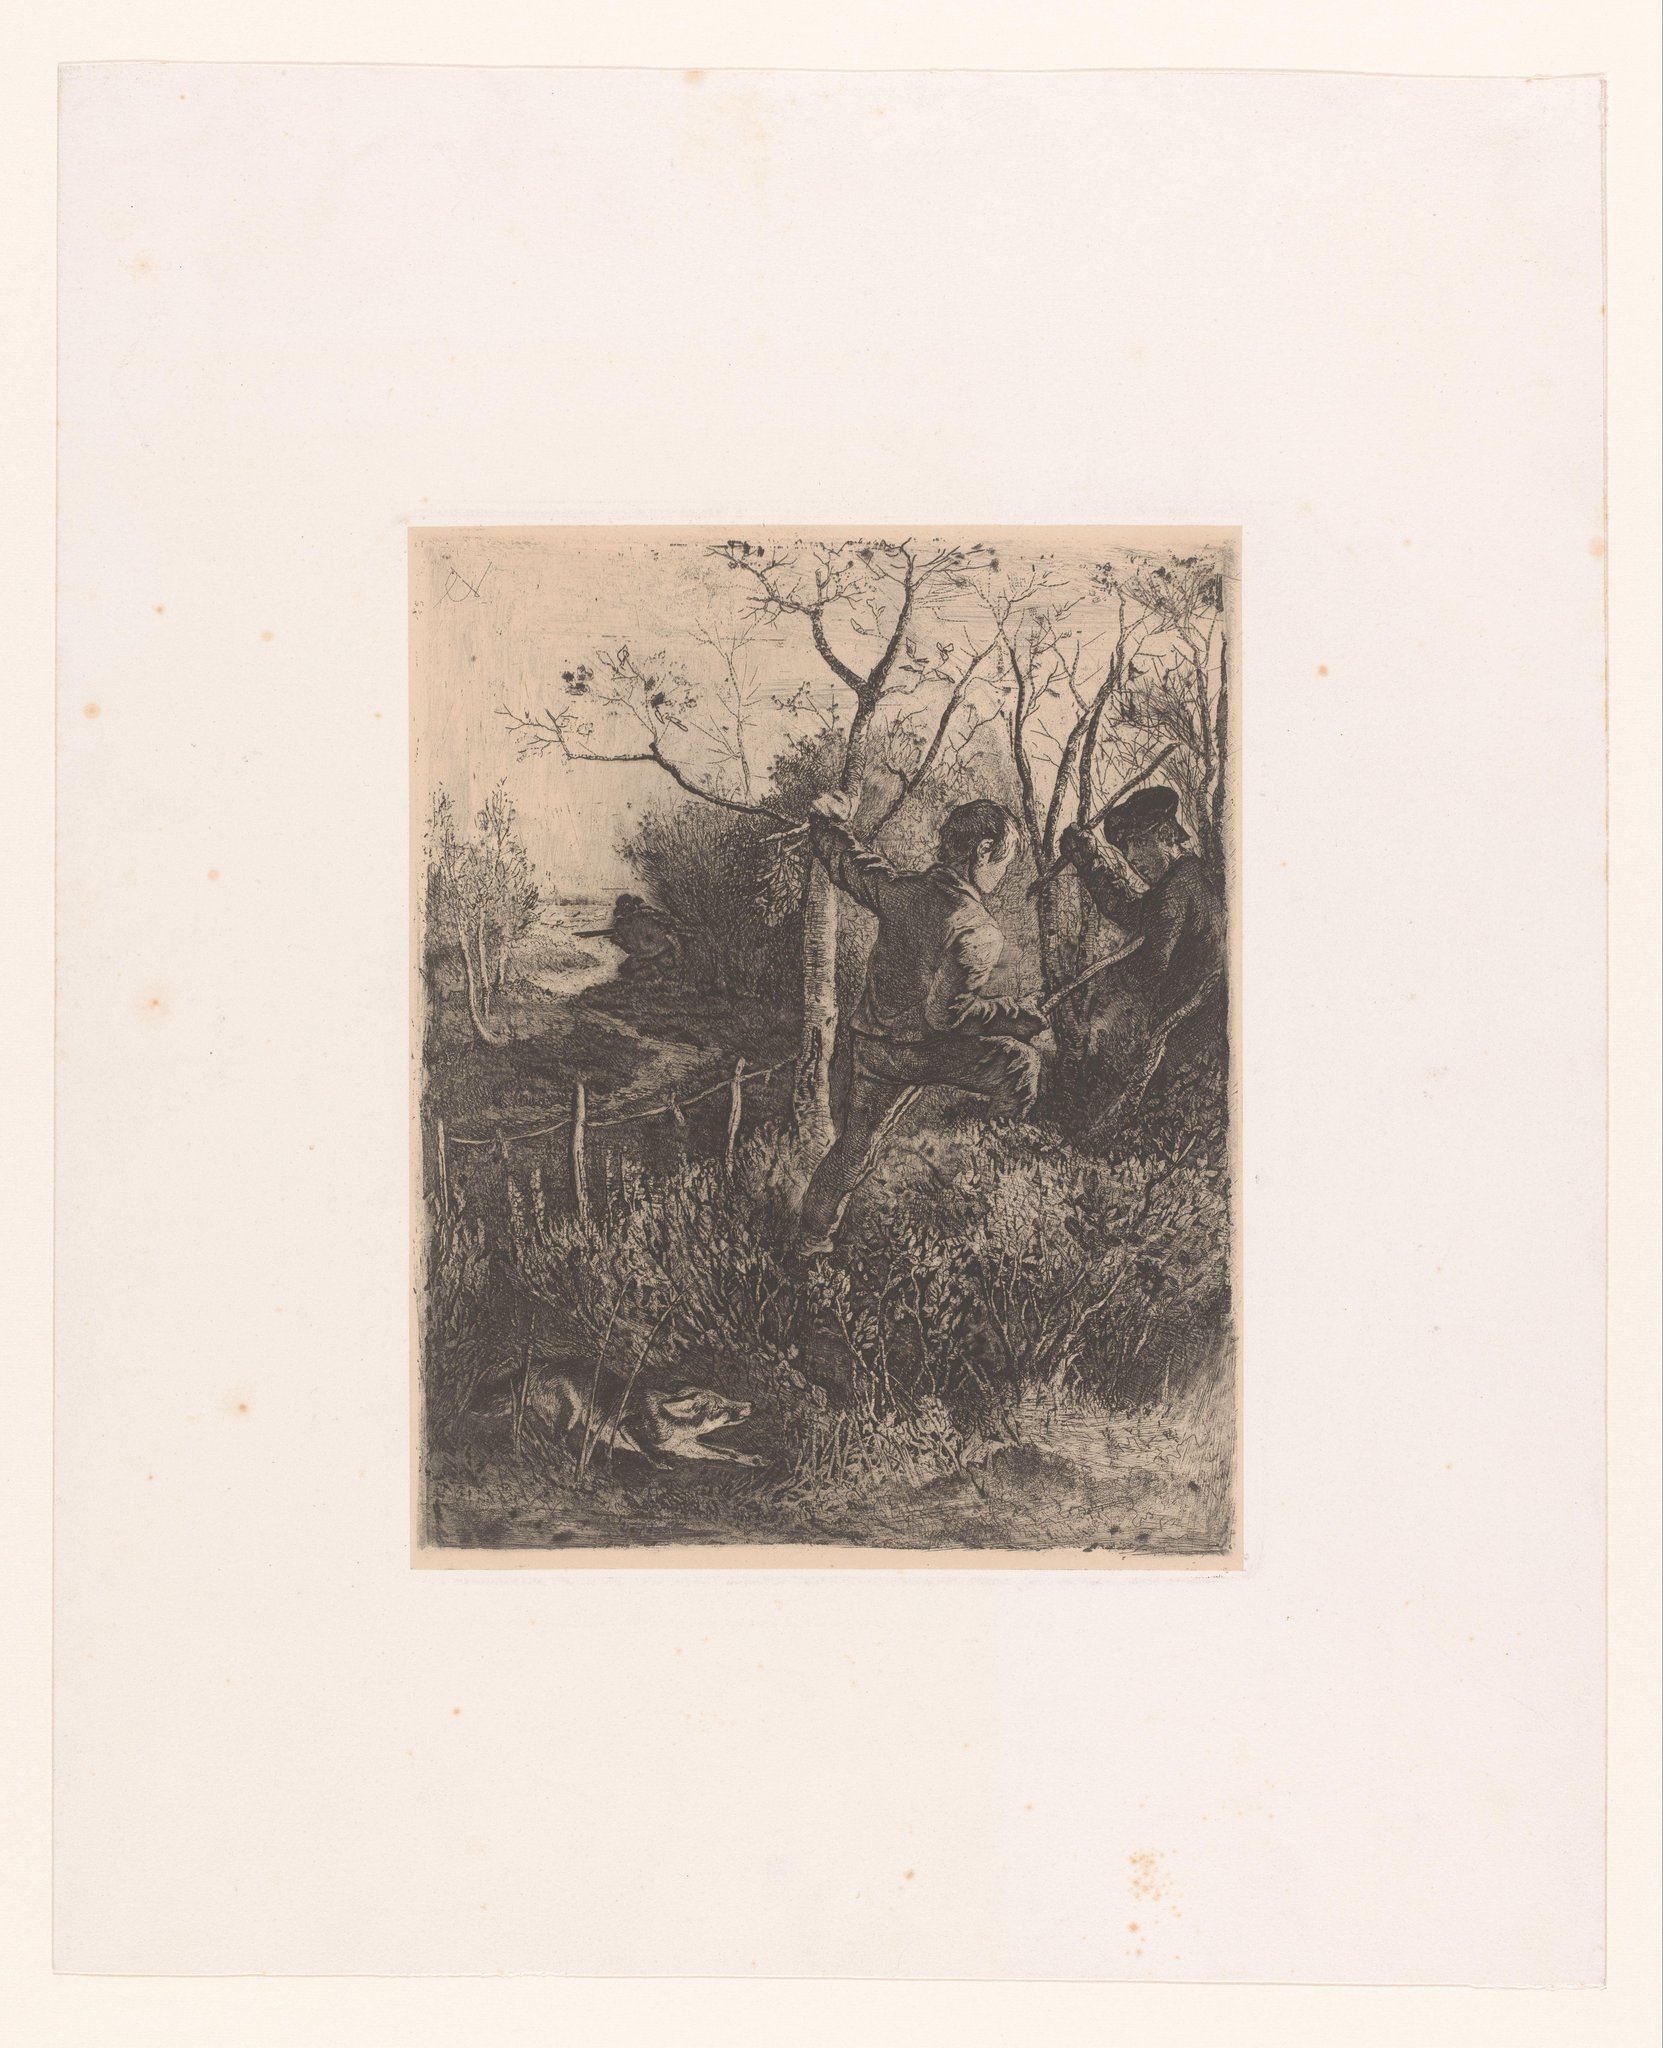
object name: print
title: Landschap met jager en twee vechtende jongens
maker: charles verlat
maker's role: painter, print maker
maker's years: 1824-1890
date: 1834-1890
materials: paper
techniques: aquatint, drypoint, etching, intaglio, retroussage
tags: landscapes, hunter, fighting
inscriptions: collector's mark: Lugt 2228